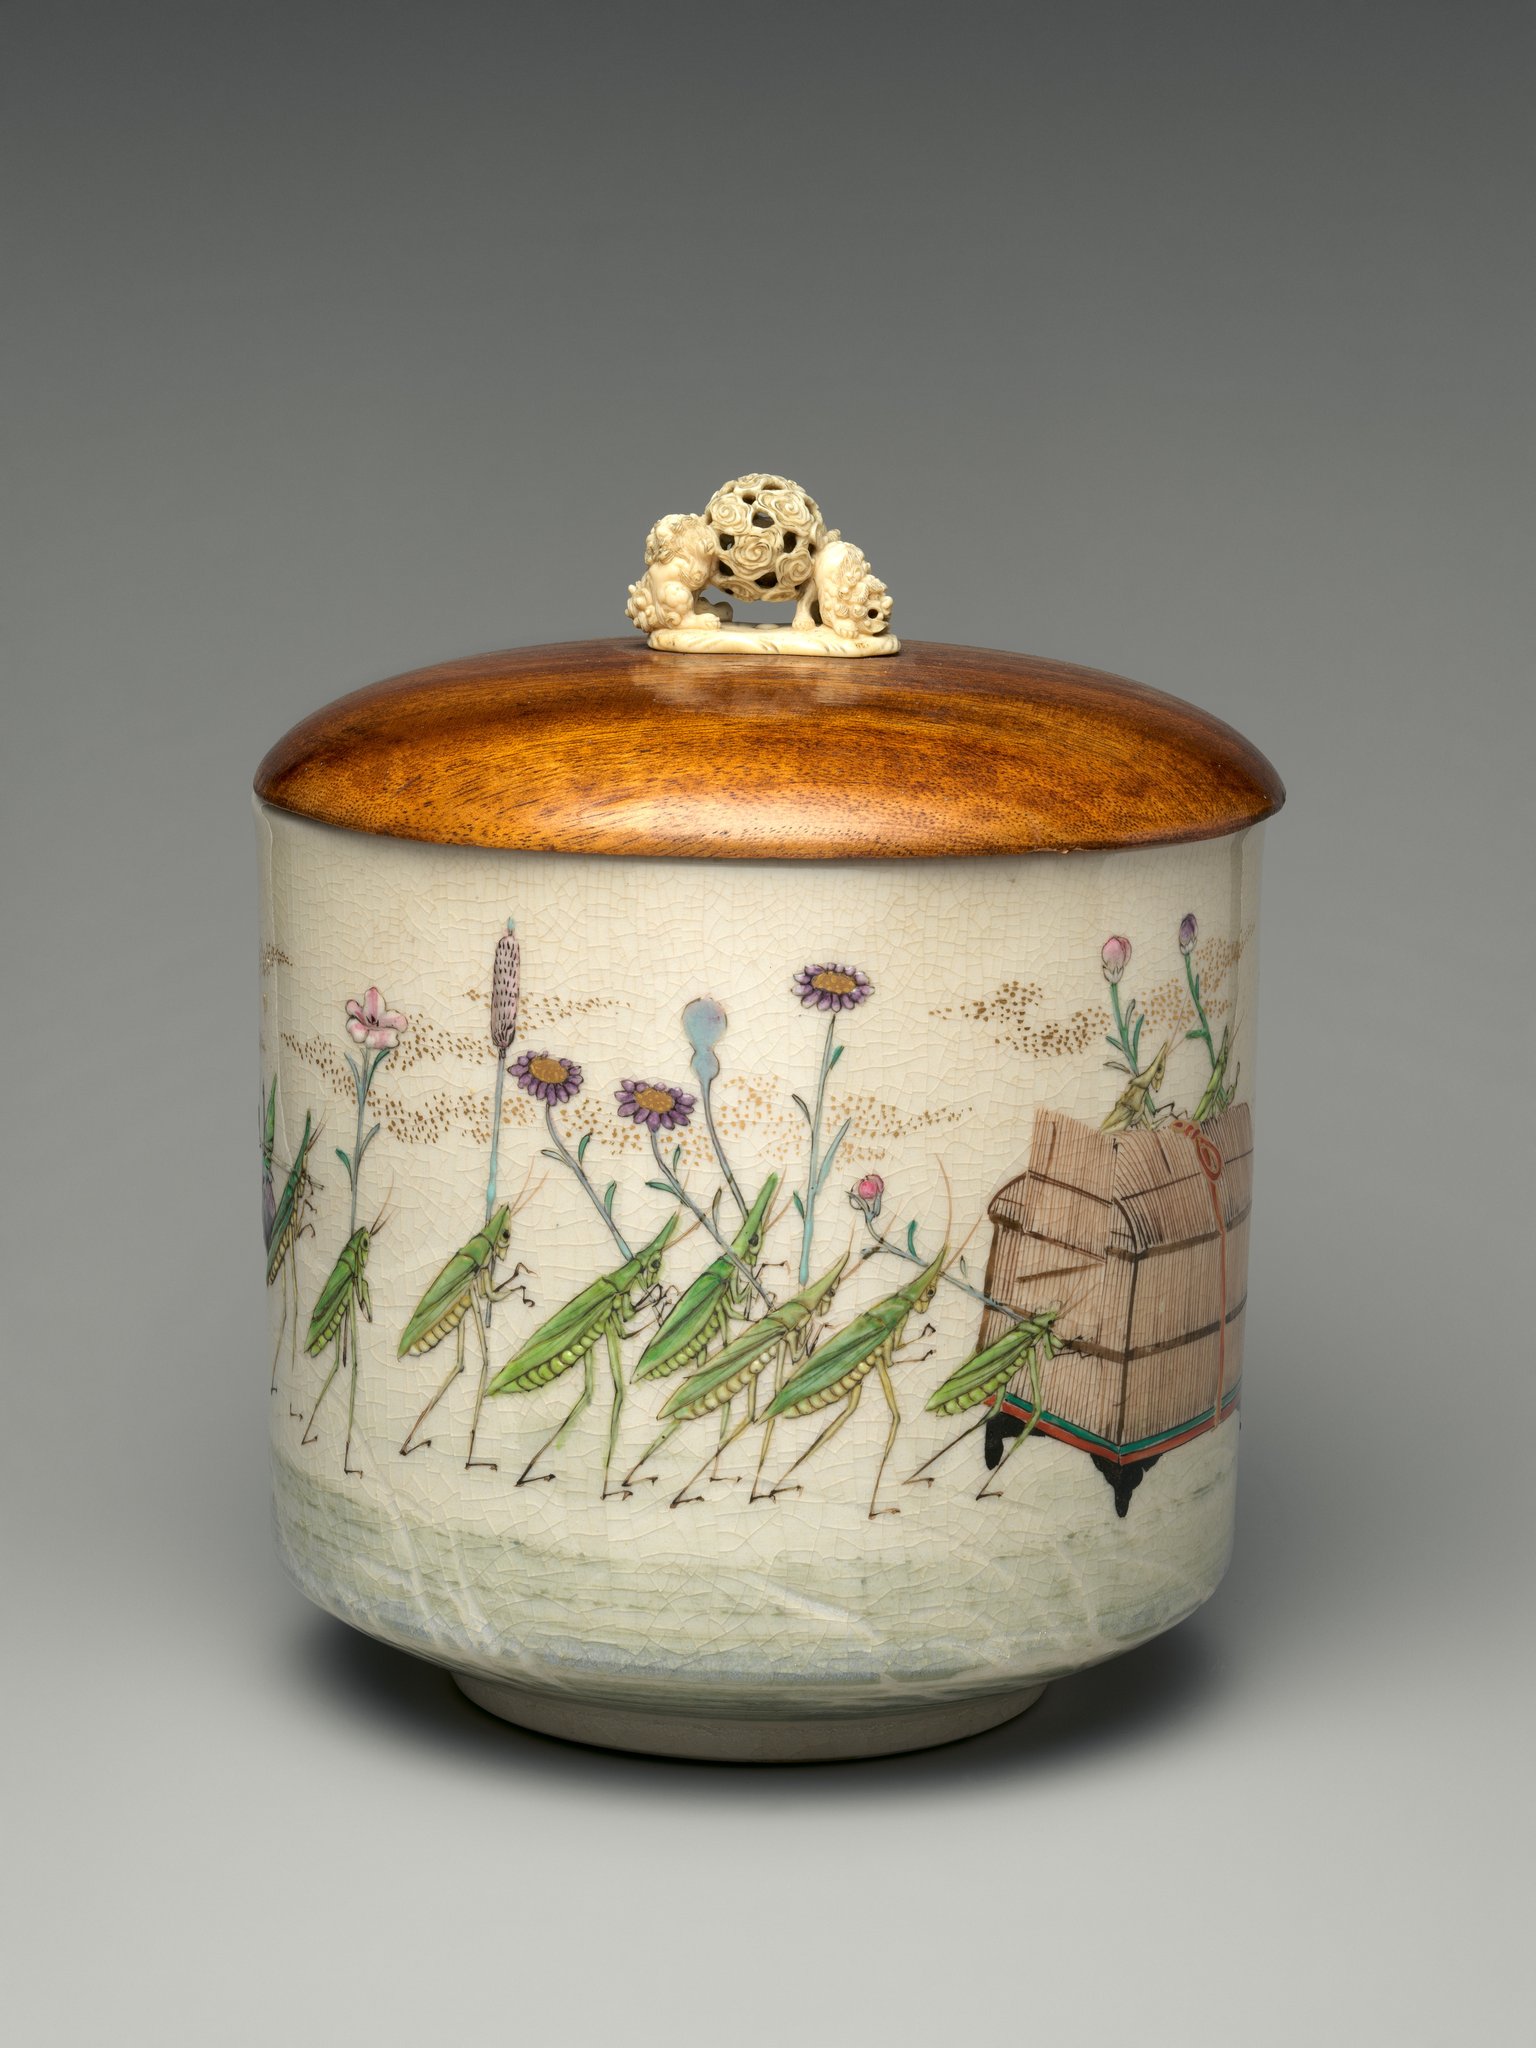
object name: freshwater jar mizusashi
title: Freshwater Jar (Mizusashi)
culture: japanese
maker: makuzu kōzan i (miyagawa toranosuke)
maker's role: artist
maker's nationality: japanese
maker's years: 1842-1916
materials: enamel, gold, ivory, stoneware, wood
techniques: overglaze, polychrome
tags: insects,flowers